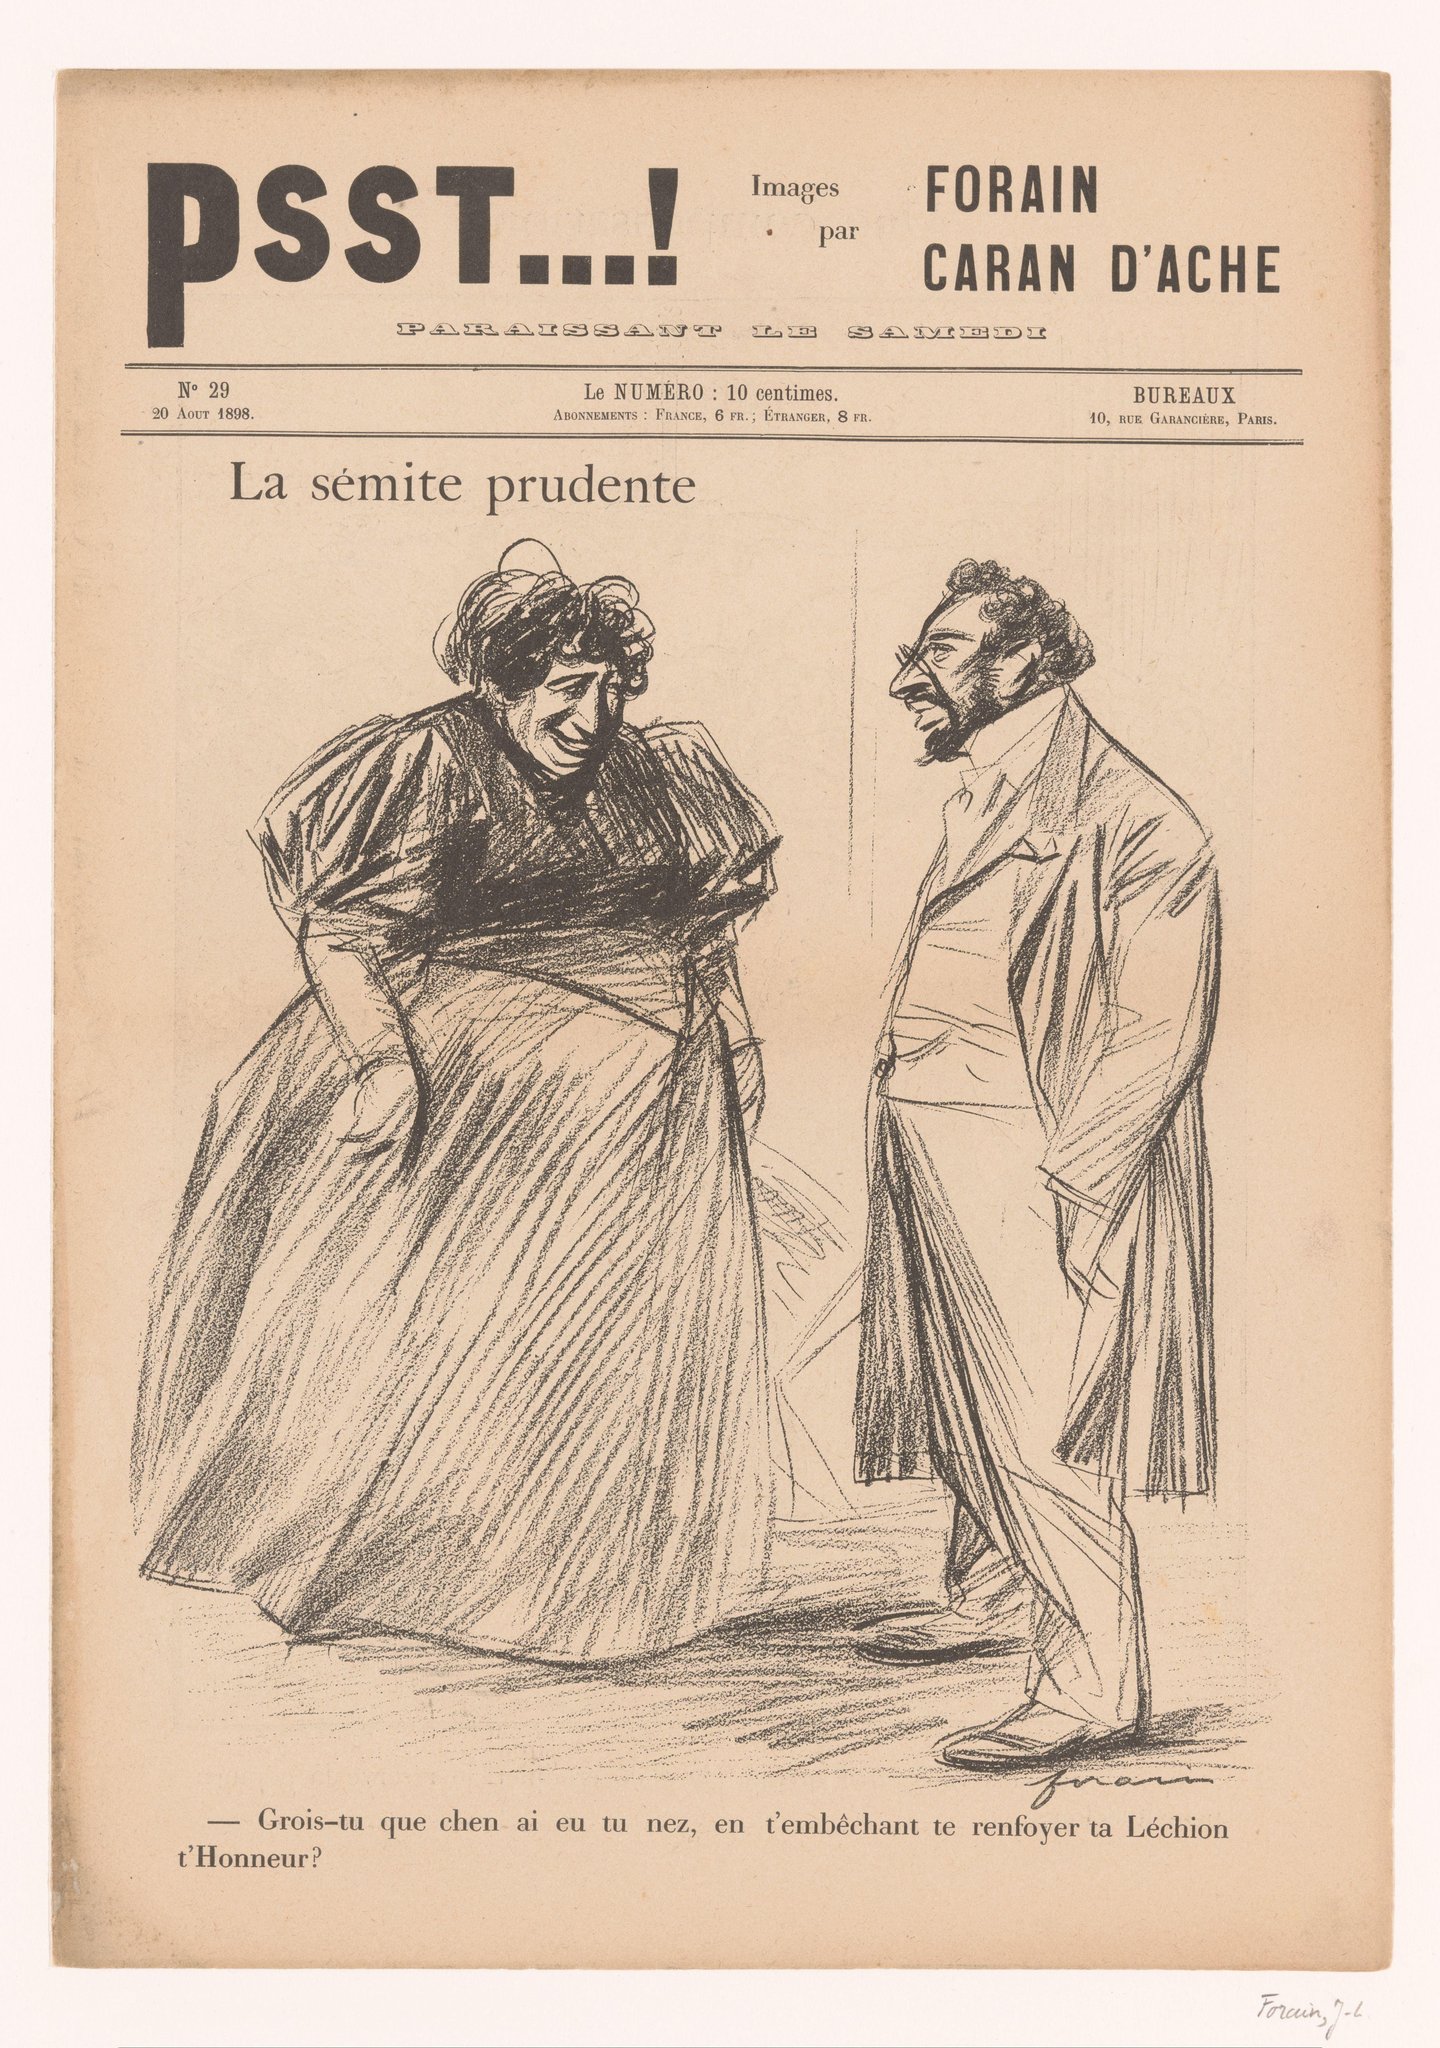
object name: magazine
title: La sémite prudente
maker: jean-louis forain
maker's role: painter, print maker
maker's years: 1852-1931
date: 1898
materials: paper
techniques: lithograph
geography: paris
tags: paris, caricatures (human types), historical persons, political caricatures and satires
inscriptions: date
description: Prent gebruikt voor: Psst...!, nr. 29, 20 augustus 1898. Psst..! was een politieke weekkrant met antisemitische en anti-Dreyfus cartoons.